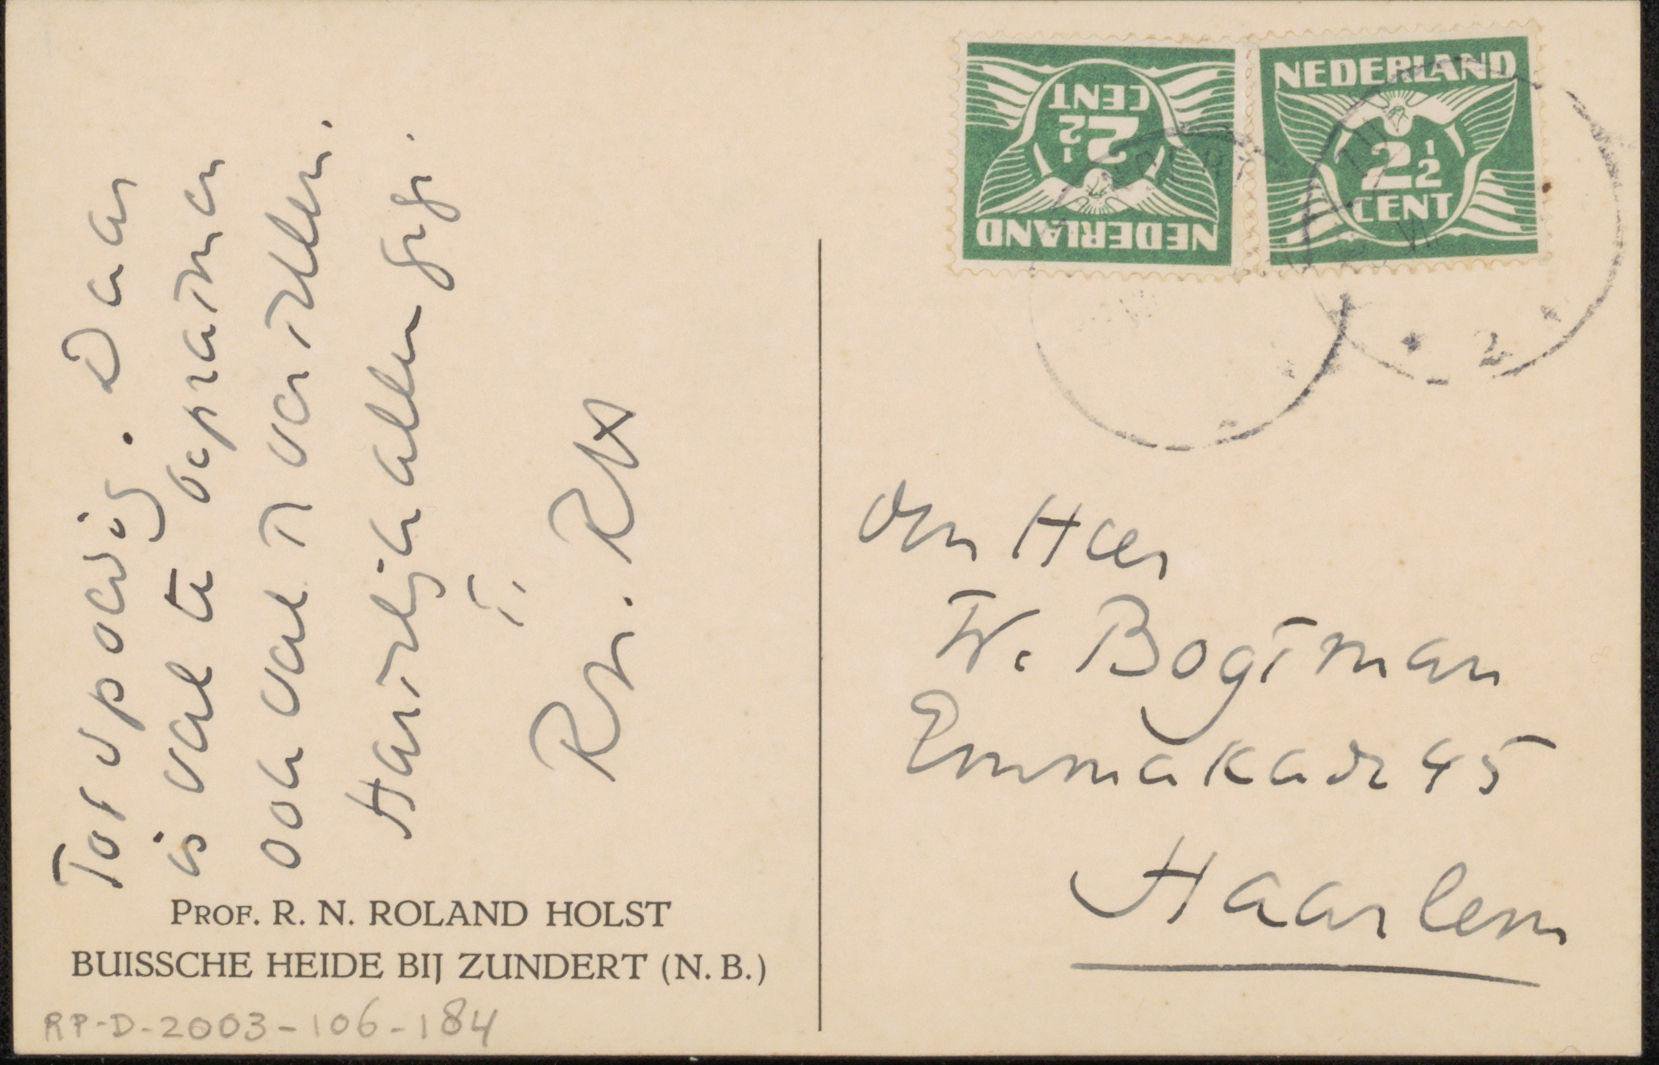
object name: postcard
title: Briefkaart aan Willem Bogtman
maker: richard nicolaüs roland holst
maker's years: 1868-1938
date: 1934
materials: cardboard, ink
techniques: pen, printing, writing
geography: buissche heide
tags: haarlem, willem bogtman, applied arts, arts and crafts; industrial design, london